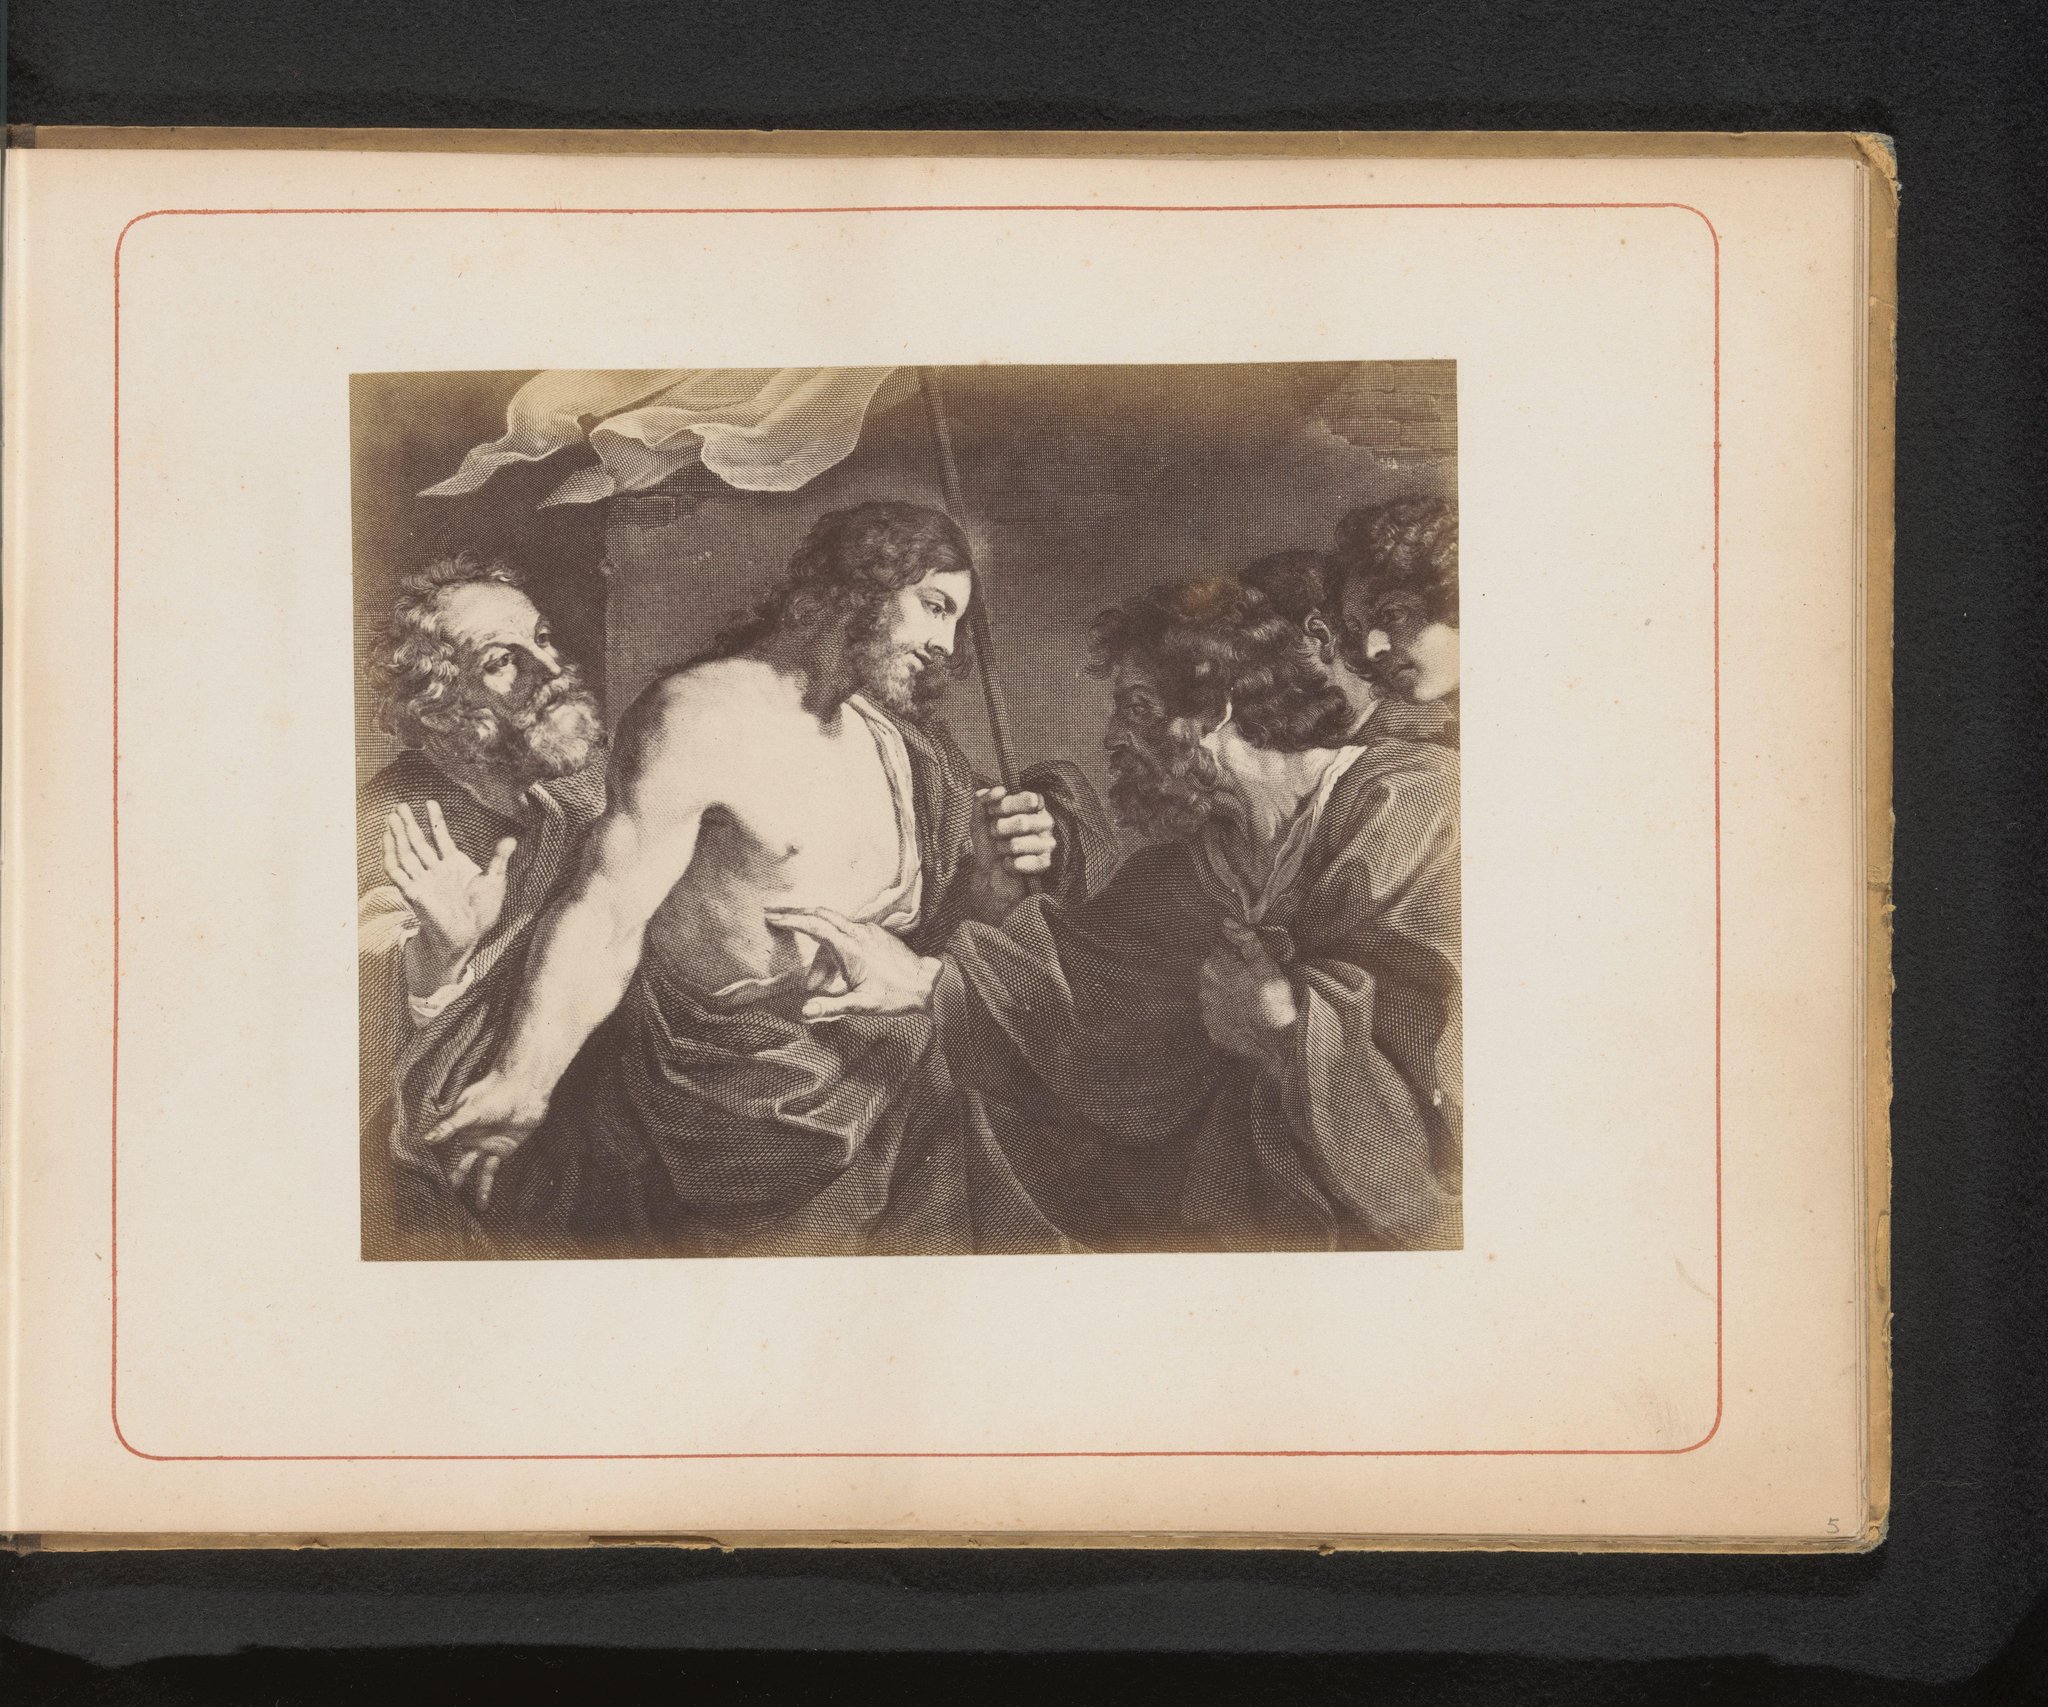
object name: page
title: Fotoreproductie van een gravure naar De ongelovigheid van de Heilige Thomas door Guercino in het Vaticaan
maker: Anonymous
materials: photographic support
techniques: albumen print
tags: the incredulity of thomas